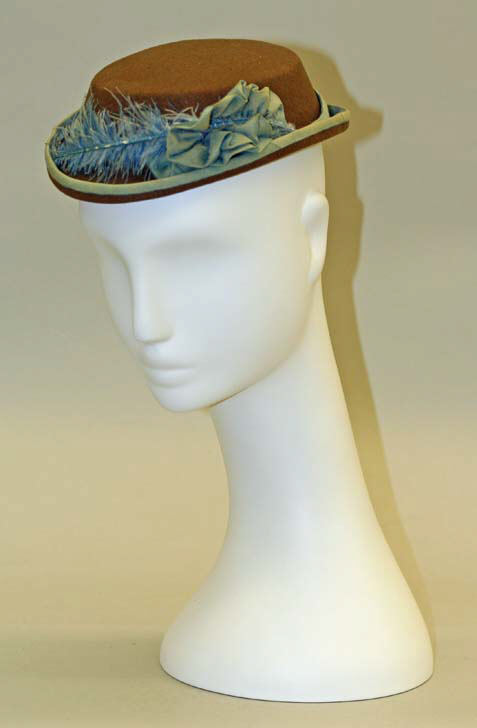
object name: hat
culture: american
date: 1868-1870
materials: wool